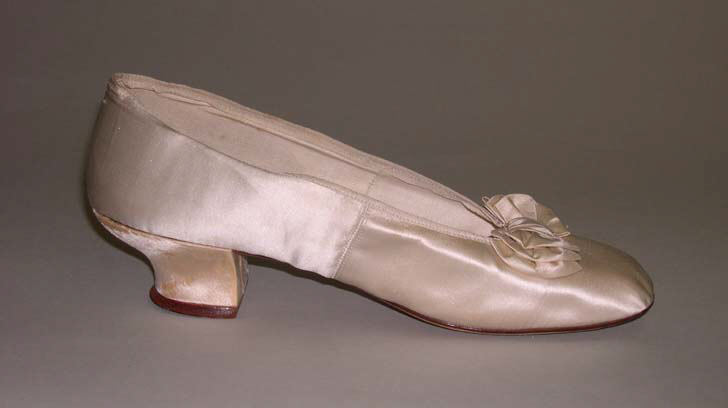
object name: slipper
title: Slippers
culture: american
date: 1882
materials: silk